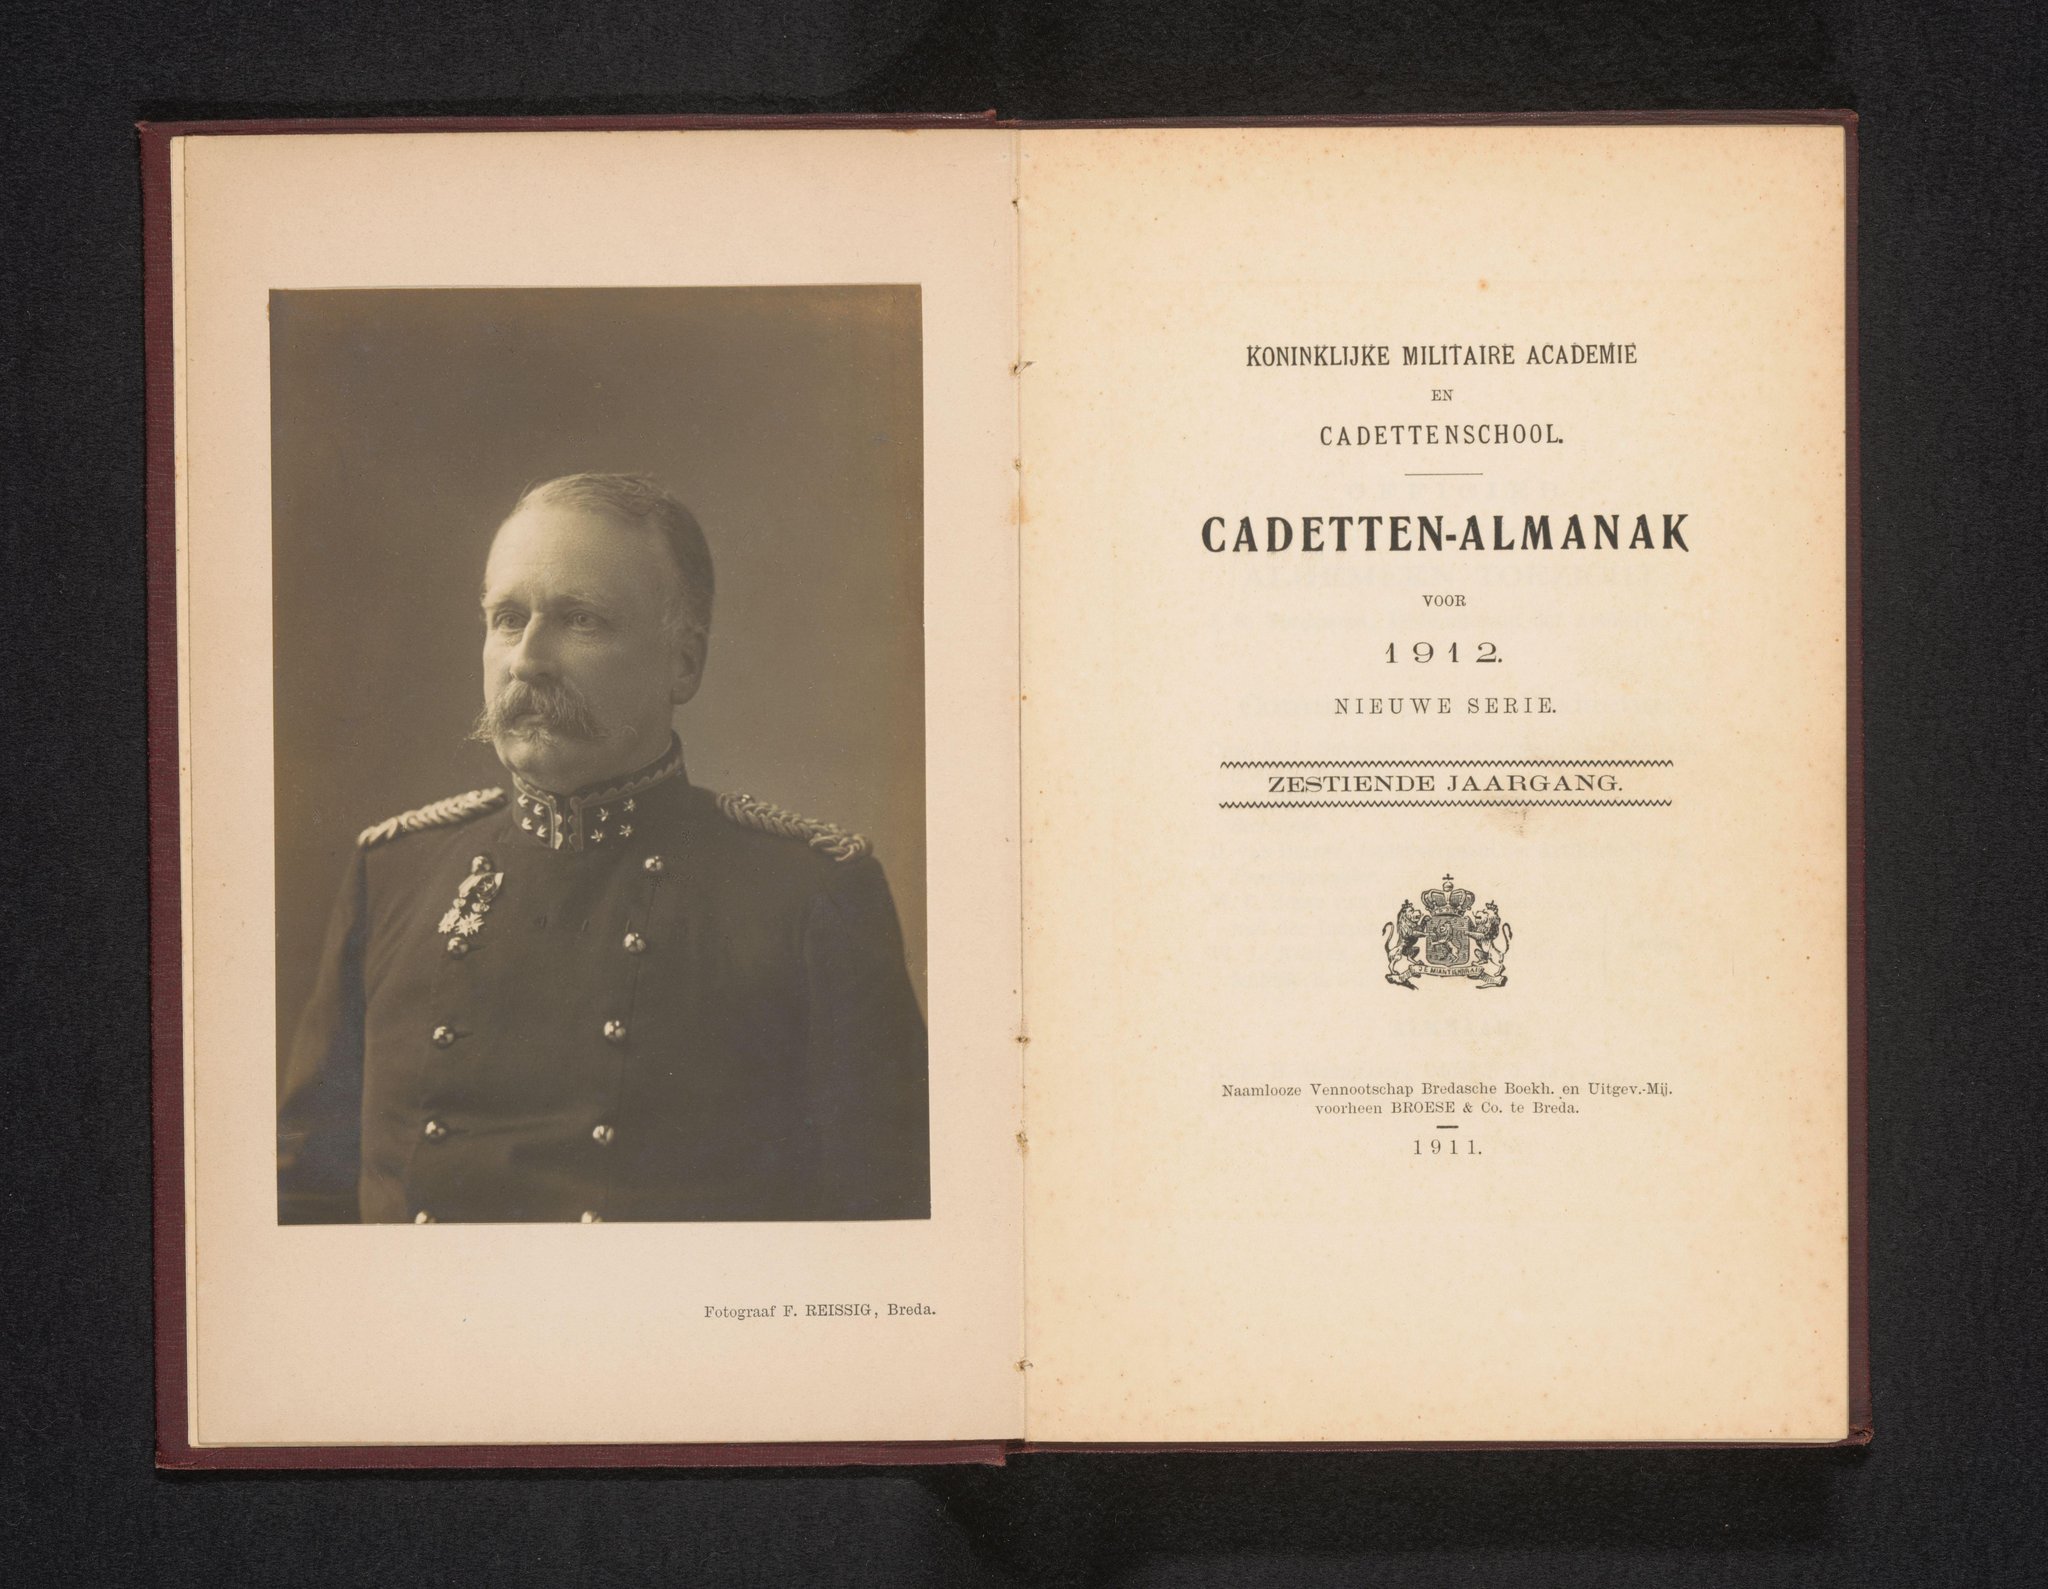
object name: photograph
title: Portret van een onbekende hooggeplaatste militair aan de Koninklijke Militaire Academie in Breda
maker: franz reissig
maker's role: fotograaf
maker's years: 1852-1936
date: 1906-1911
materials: photographic support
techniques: gelatin silver print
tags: historical persons not known by name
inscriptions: name: ‘Fotograaf F. Reissig, Breda.’